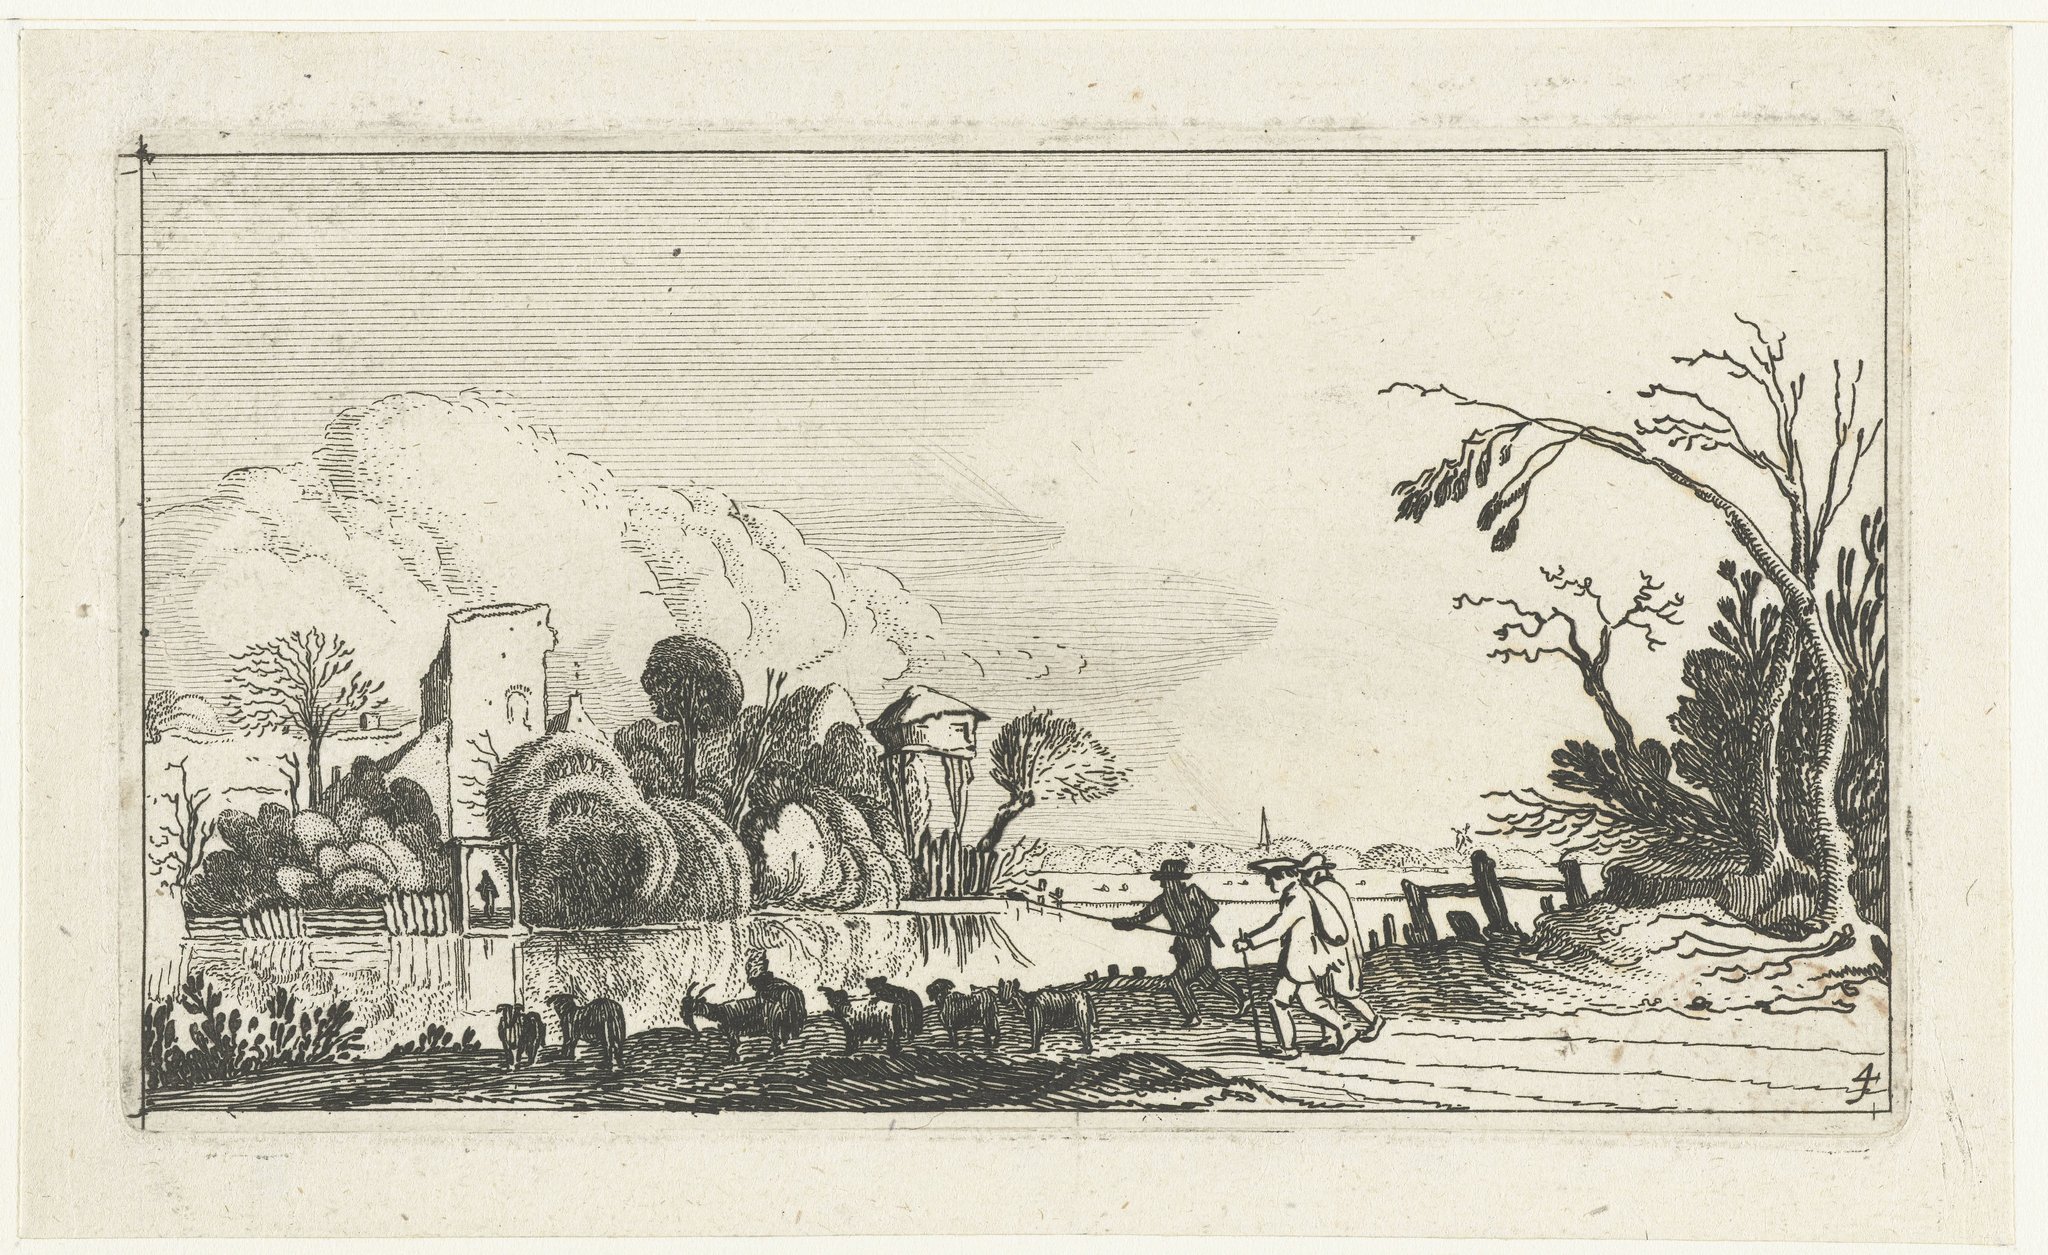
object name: print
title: Landschappen naar Esaias van de Velde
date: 1610-1650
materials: paper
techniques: etching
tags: river, herding, herdsman, herdswoman, shepherd, shepherdess, cowherd, etc.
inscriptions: collector's mark: Lugt 240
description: Tekening van Esaias v.d. Velde bevindt zich in Leipzig, vergelijk Keyes 1984, cat.nr. D 109, pl. 16